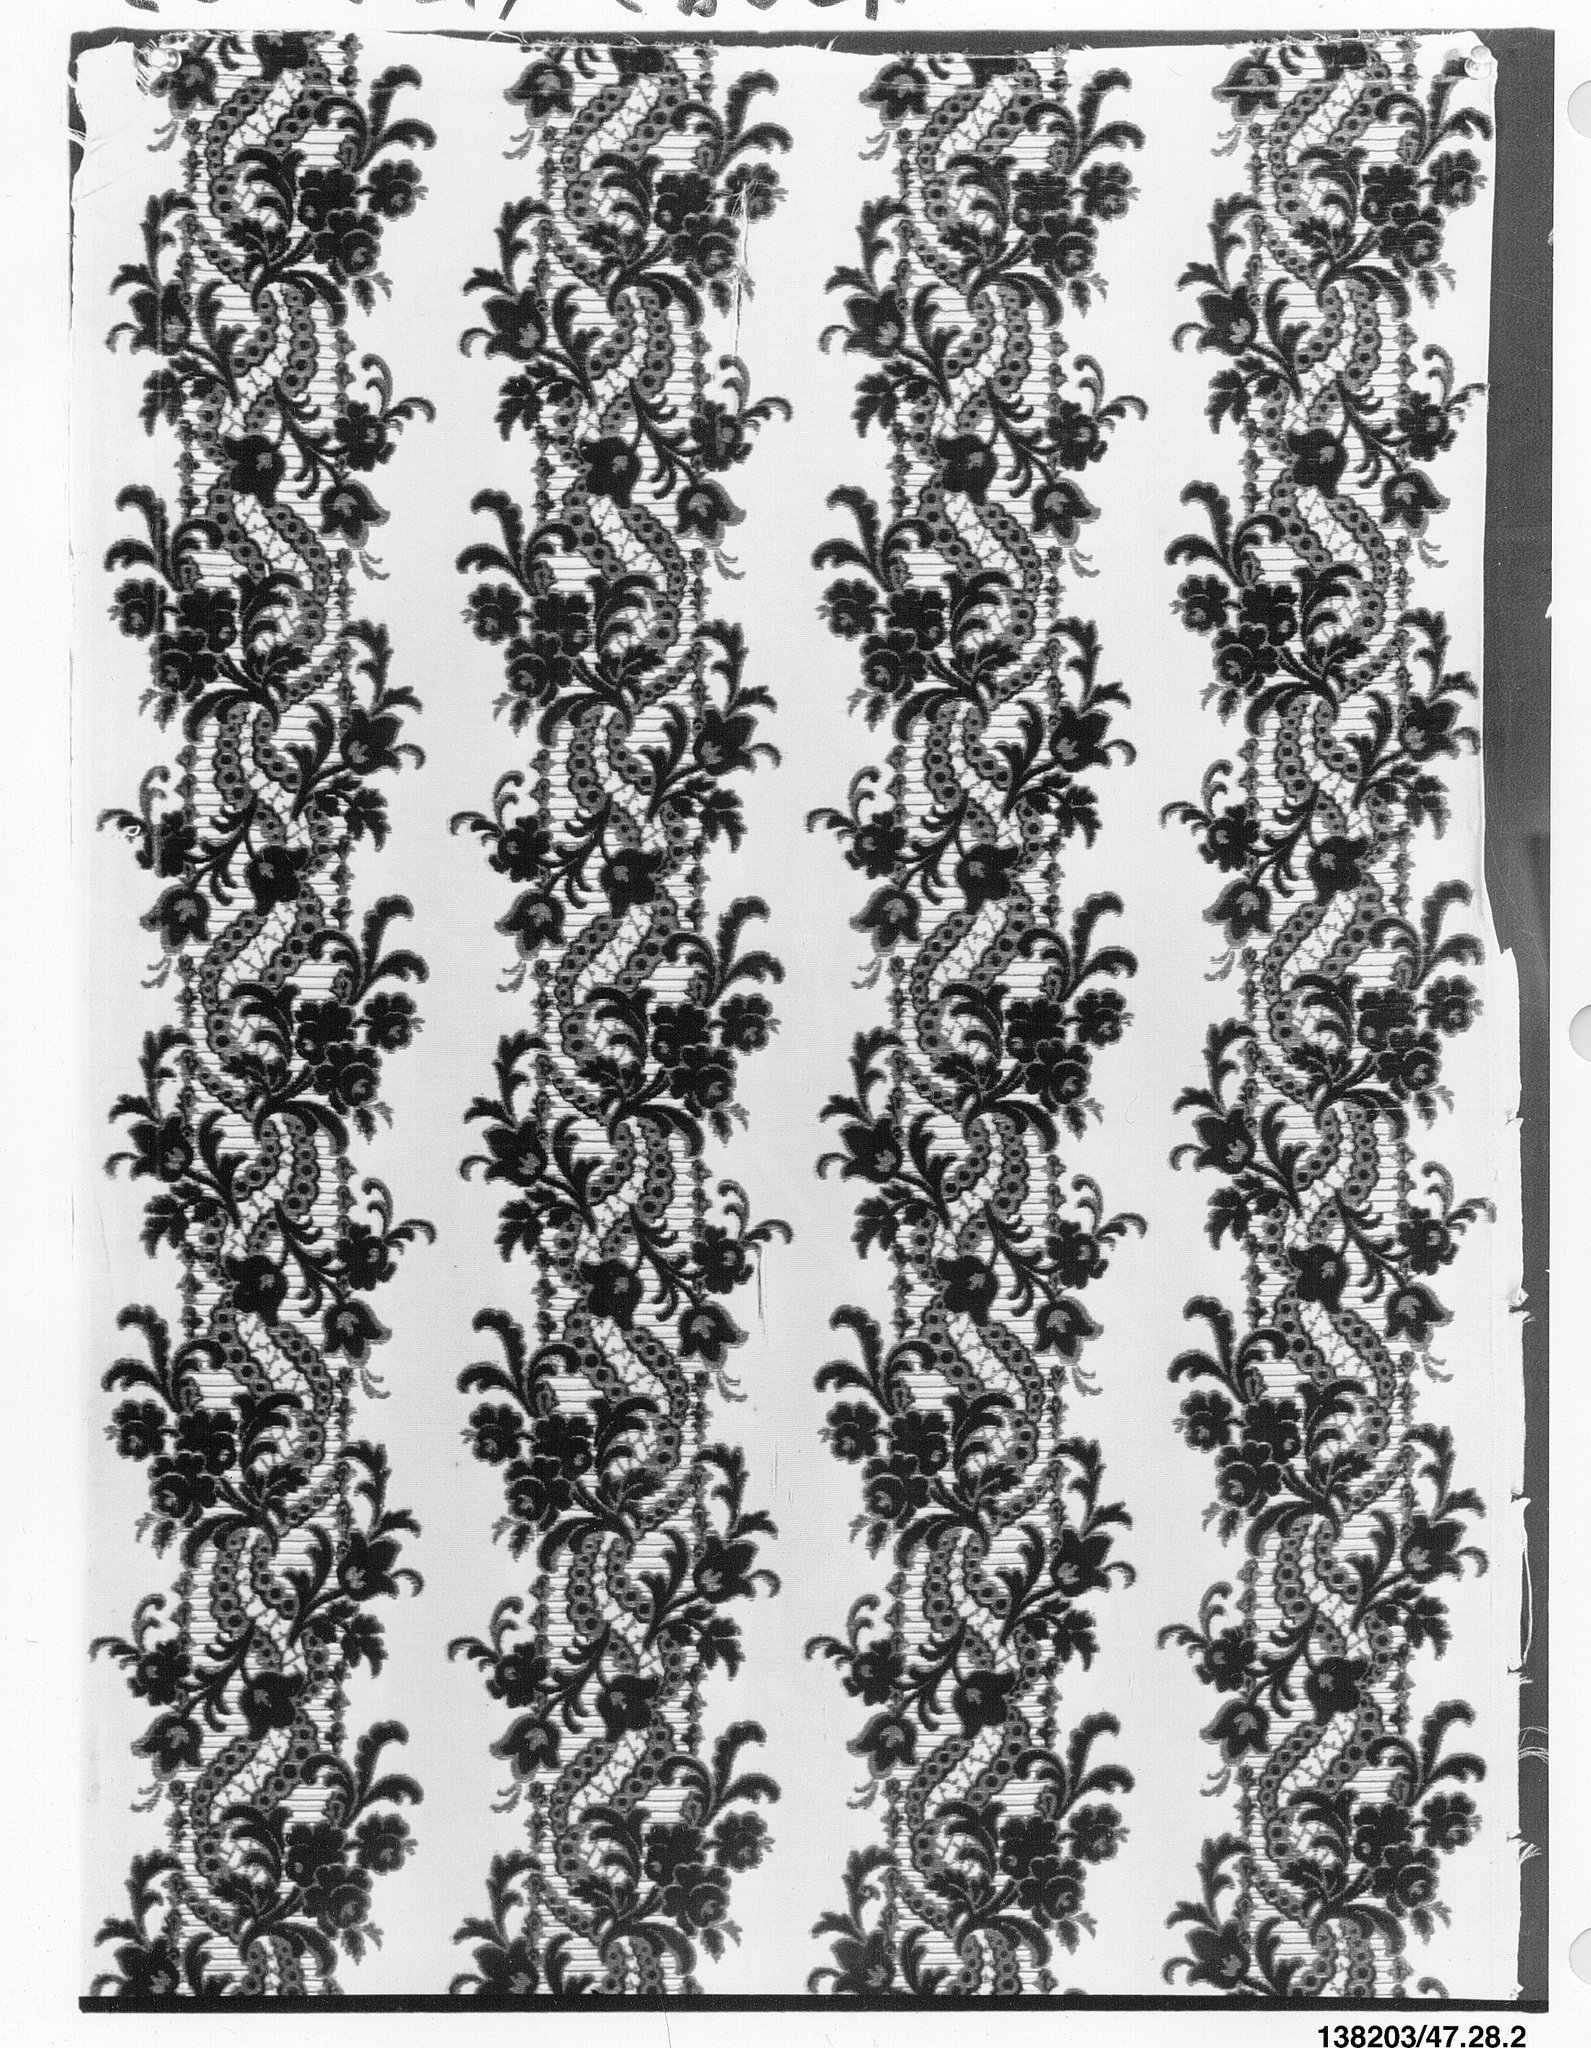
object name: piece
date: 1834-1866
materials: silk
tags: flowers,leaves